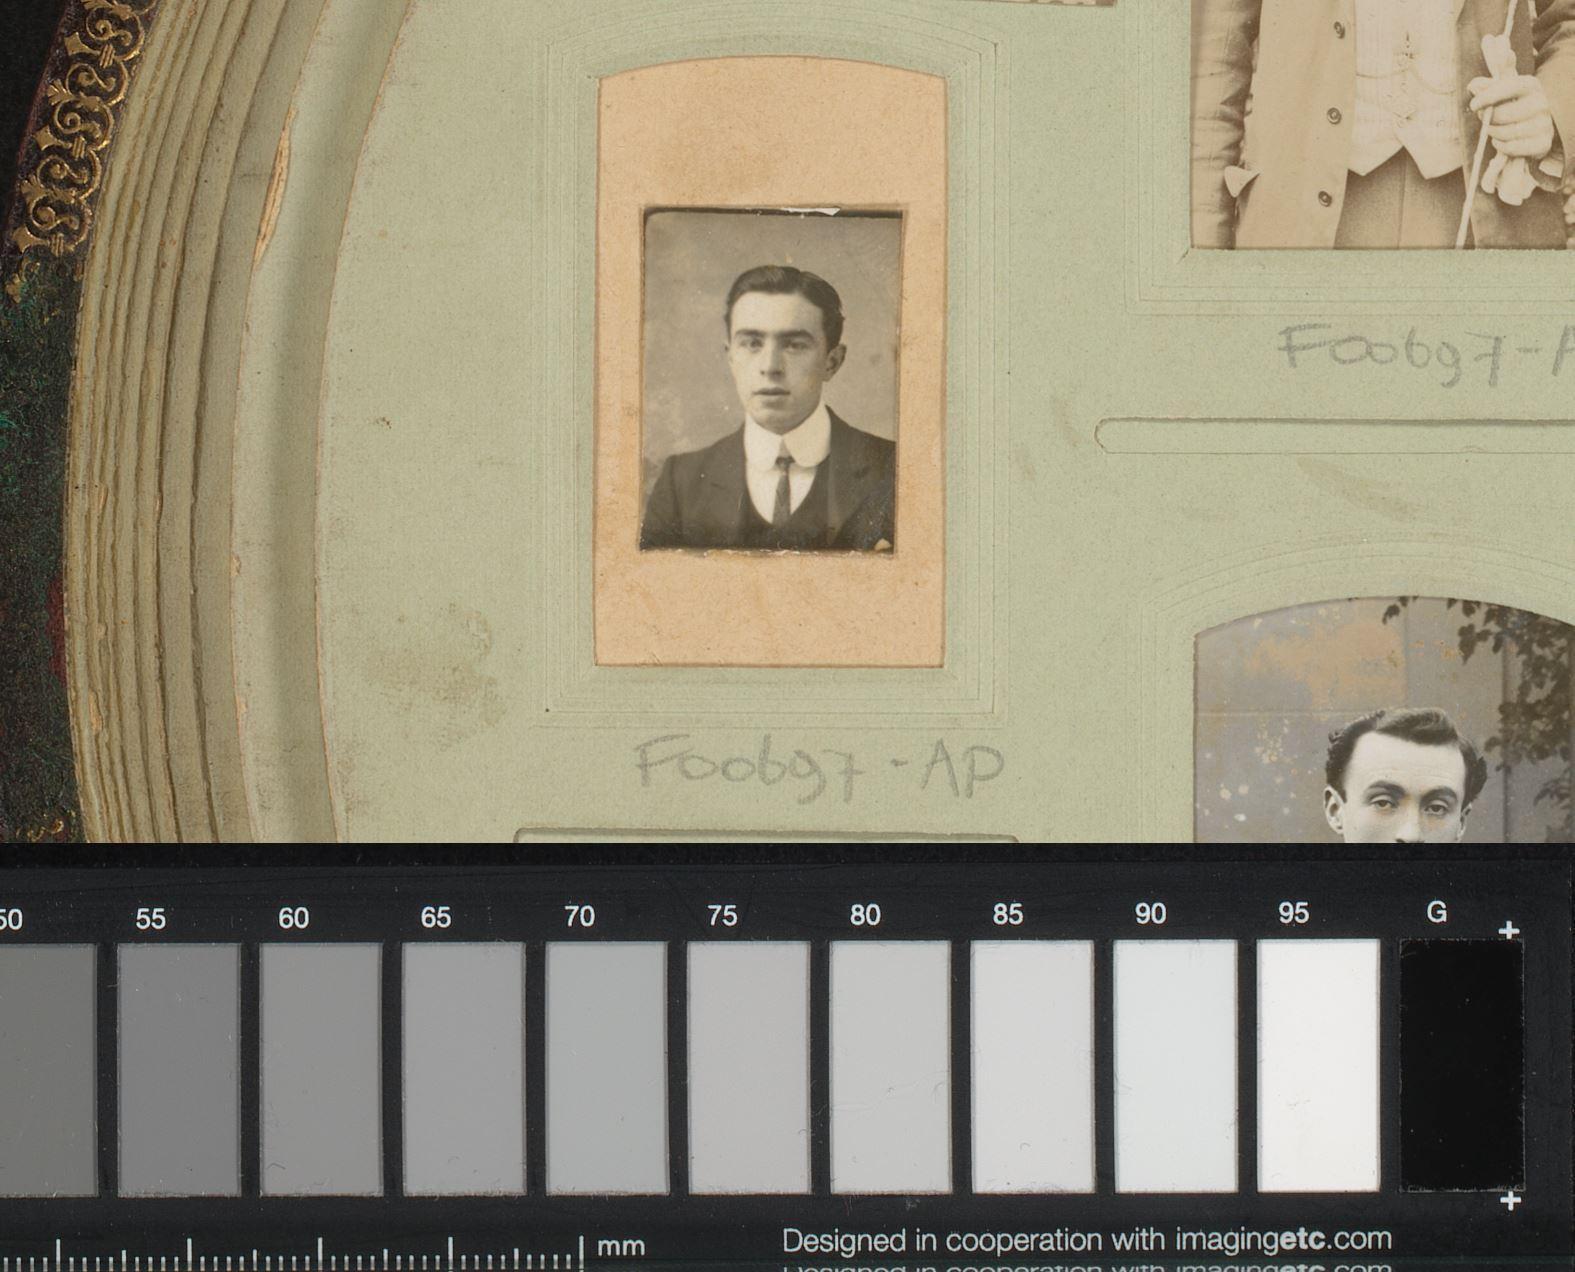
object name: snapshot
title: Portret van een man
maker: Anonymous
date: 1890-1915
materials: photographic support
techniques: gelatin silver print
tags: adult man, historical persons